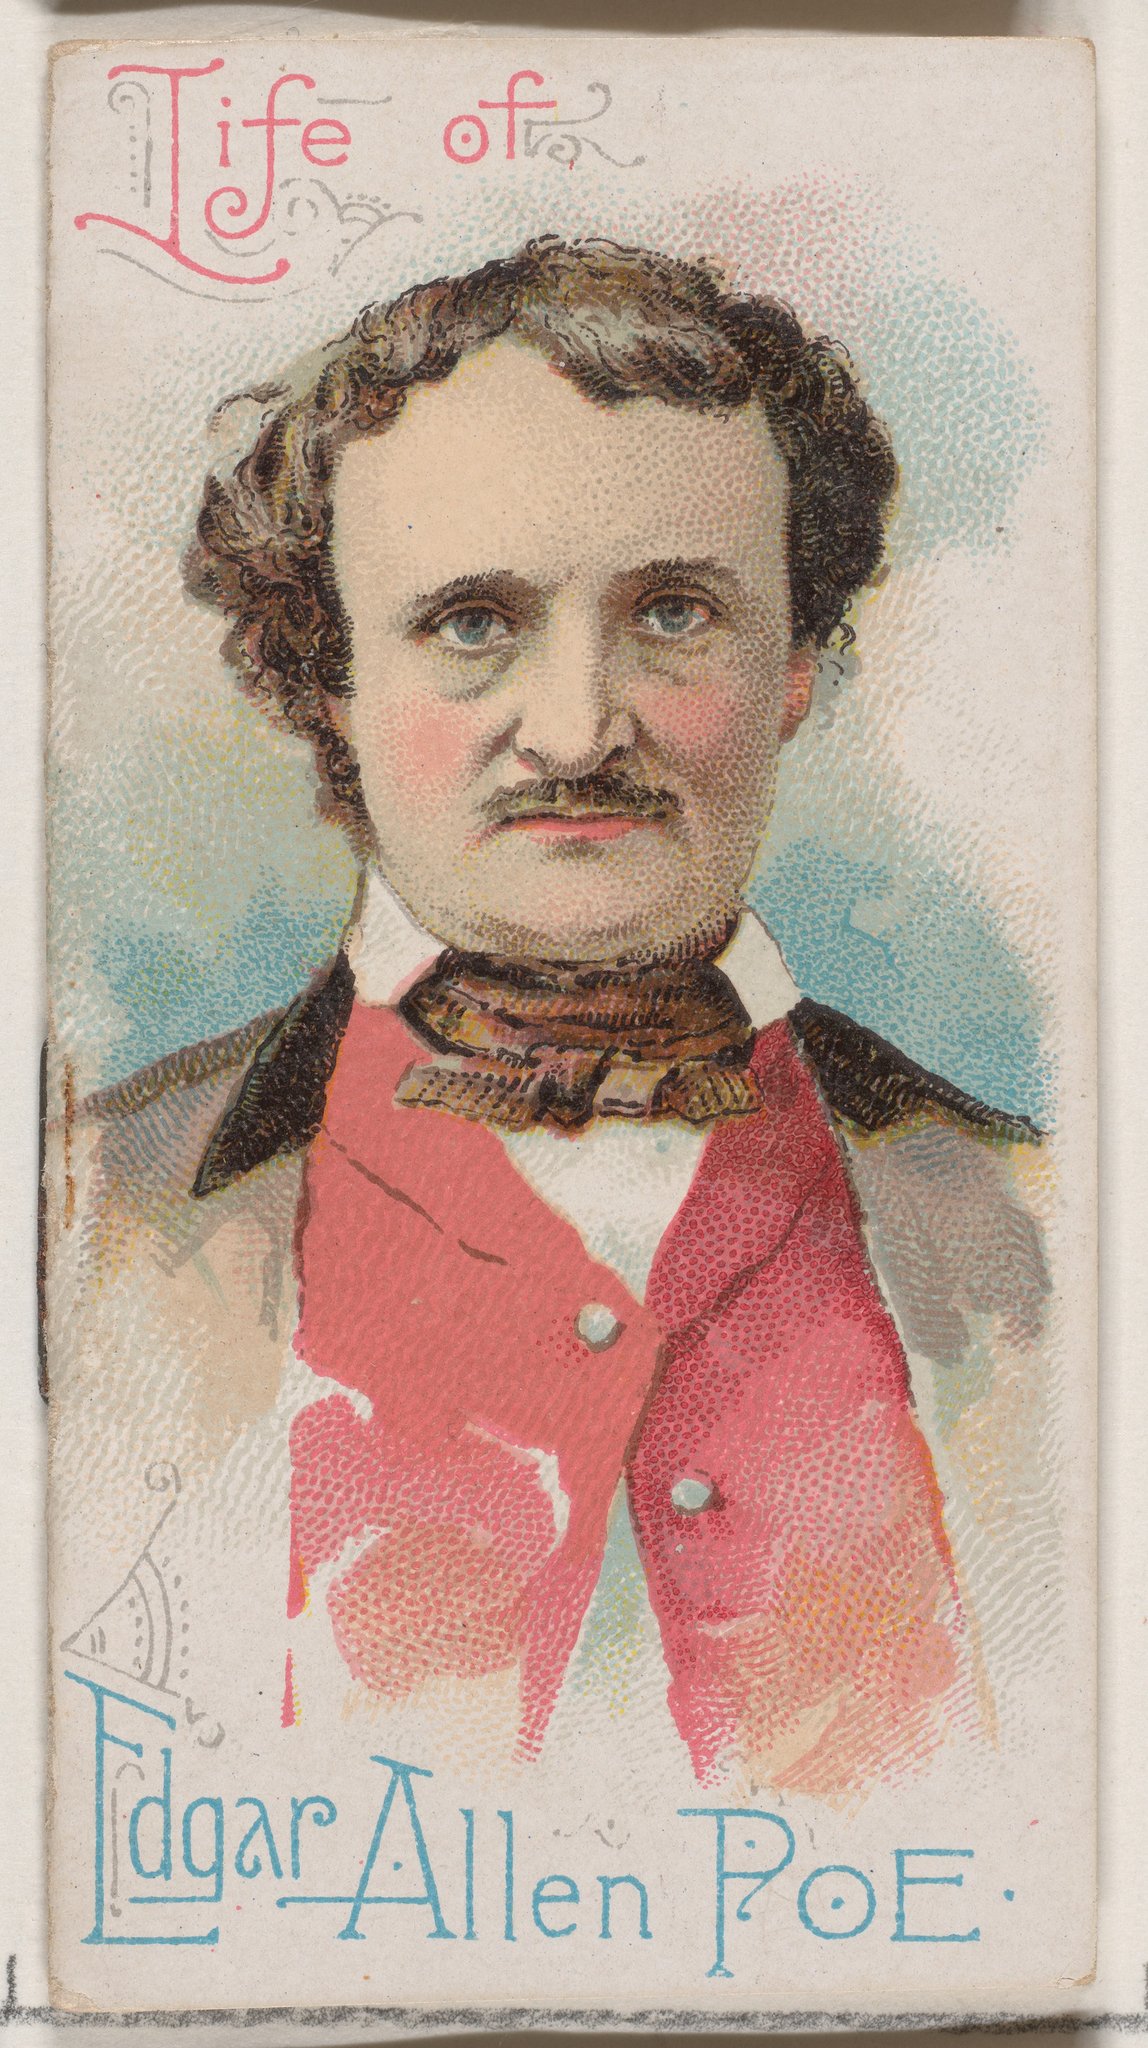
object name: print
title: History of Edgar Allan Poe, from the Histories of Poor Boys and Famous People series of booklets (N79) for Duke brand cigarettes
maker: w. duke, sons & co.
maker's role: publisher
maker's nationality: american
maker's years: 1870-1920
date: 1888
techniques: color lithograph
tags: men,portraits